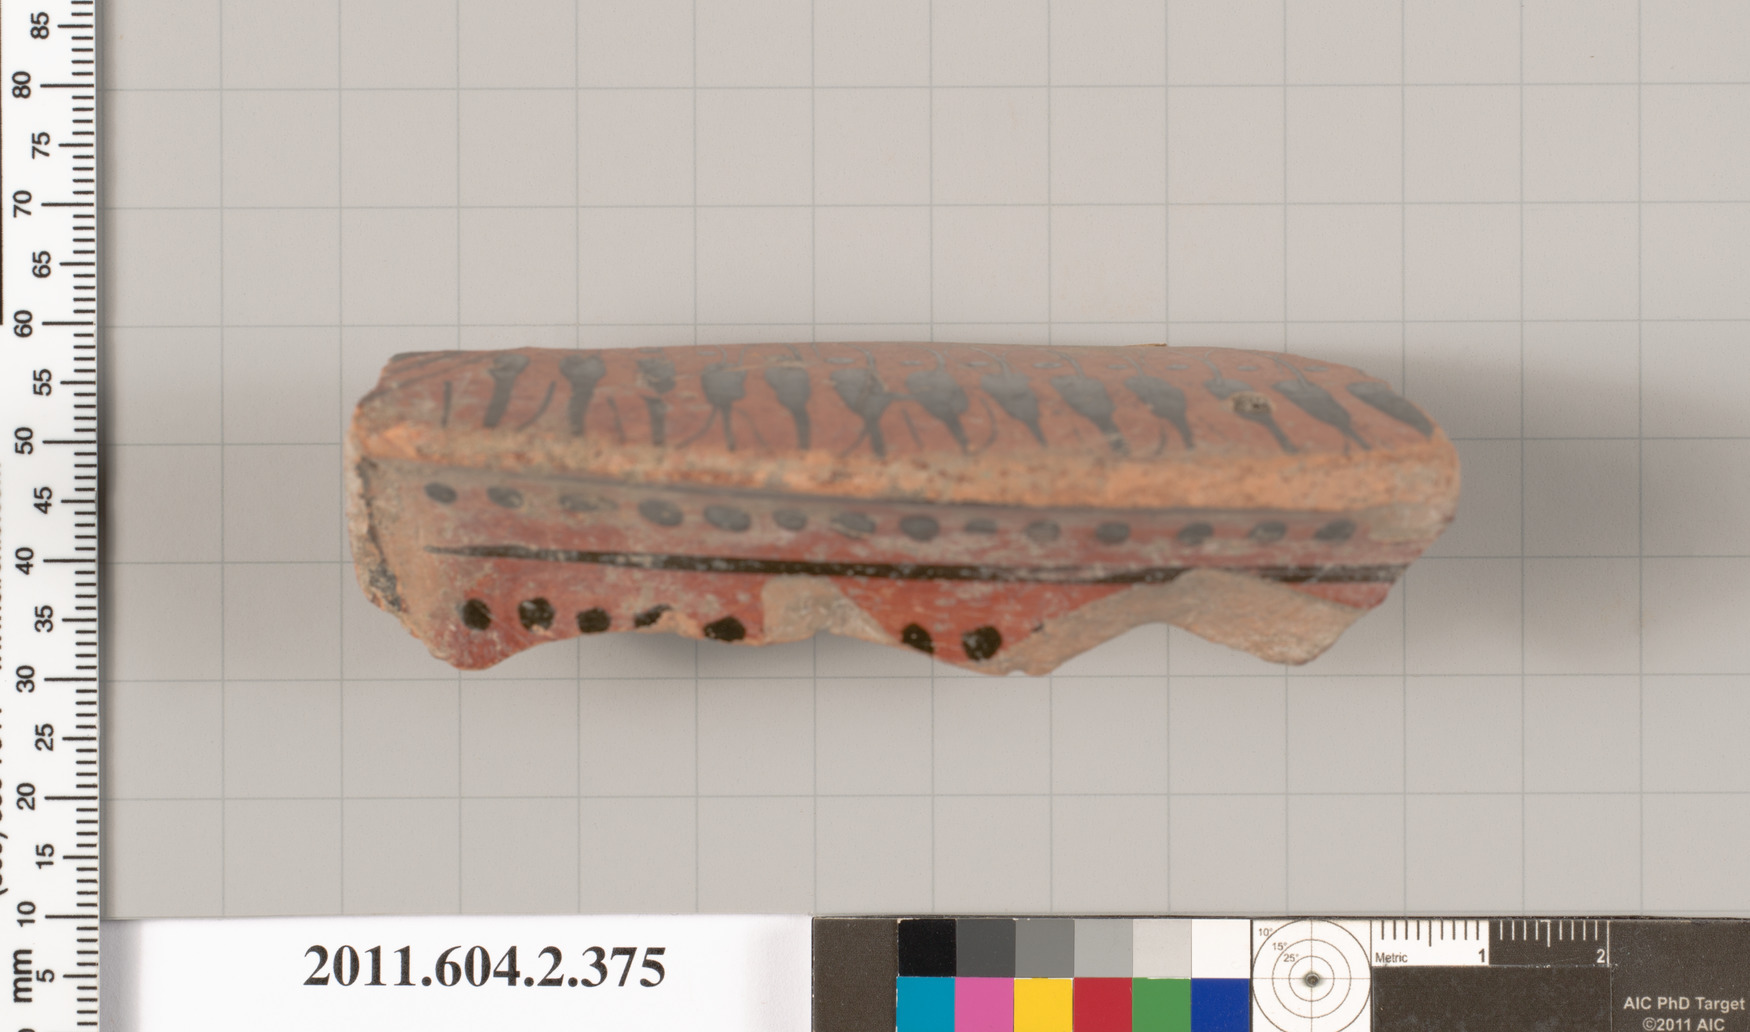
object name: column krater fragment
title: Terracotta fragment of a column-krater (bowl for mixing wine and water)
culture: greek, attic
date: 450-430 BCE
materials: terracotta